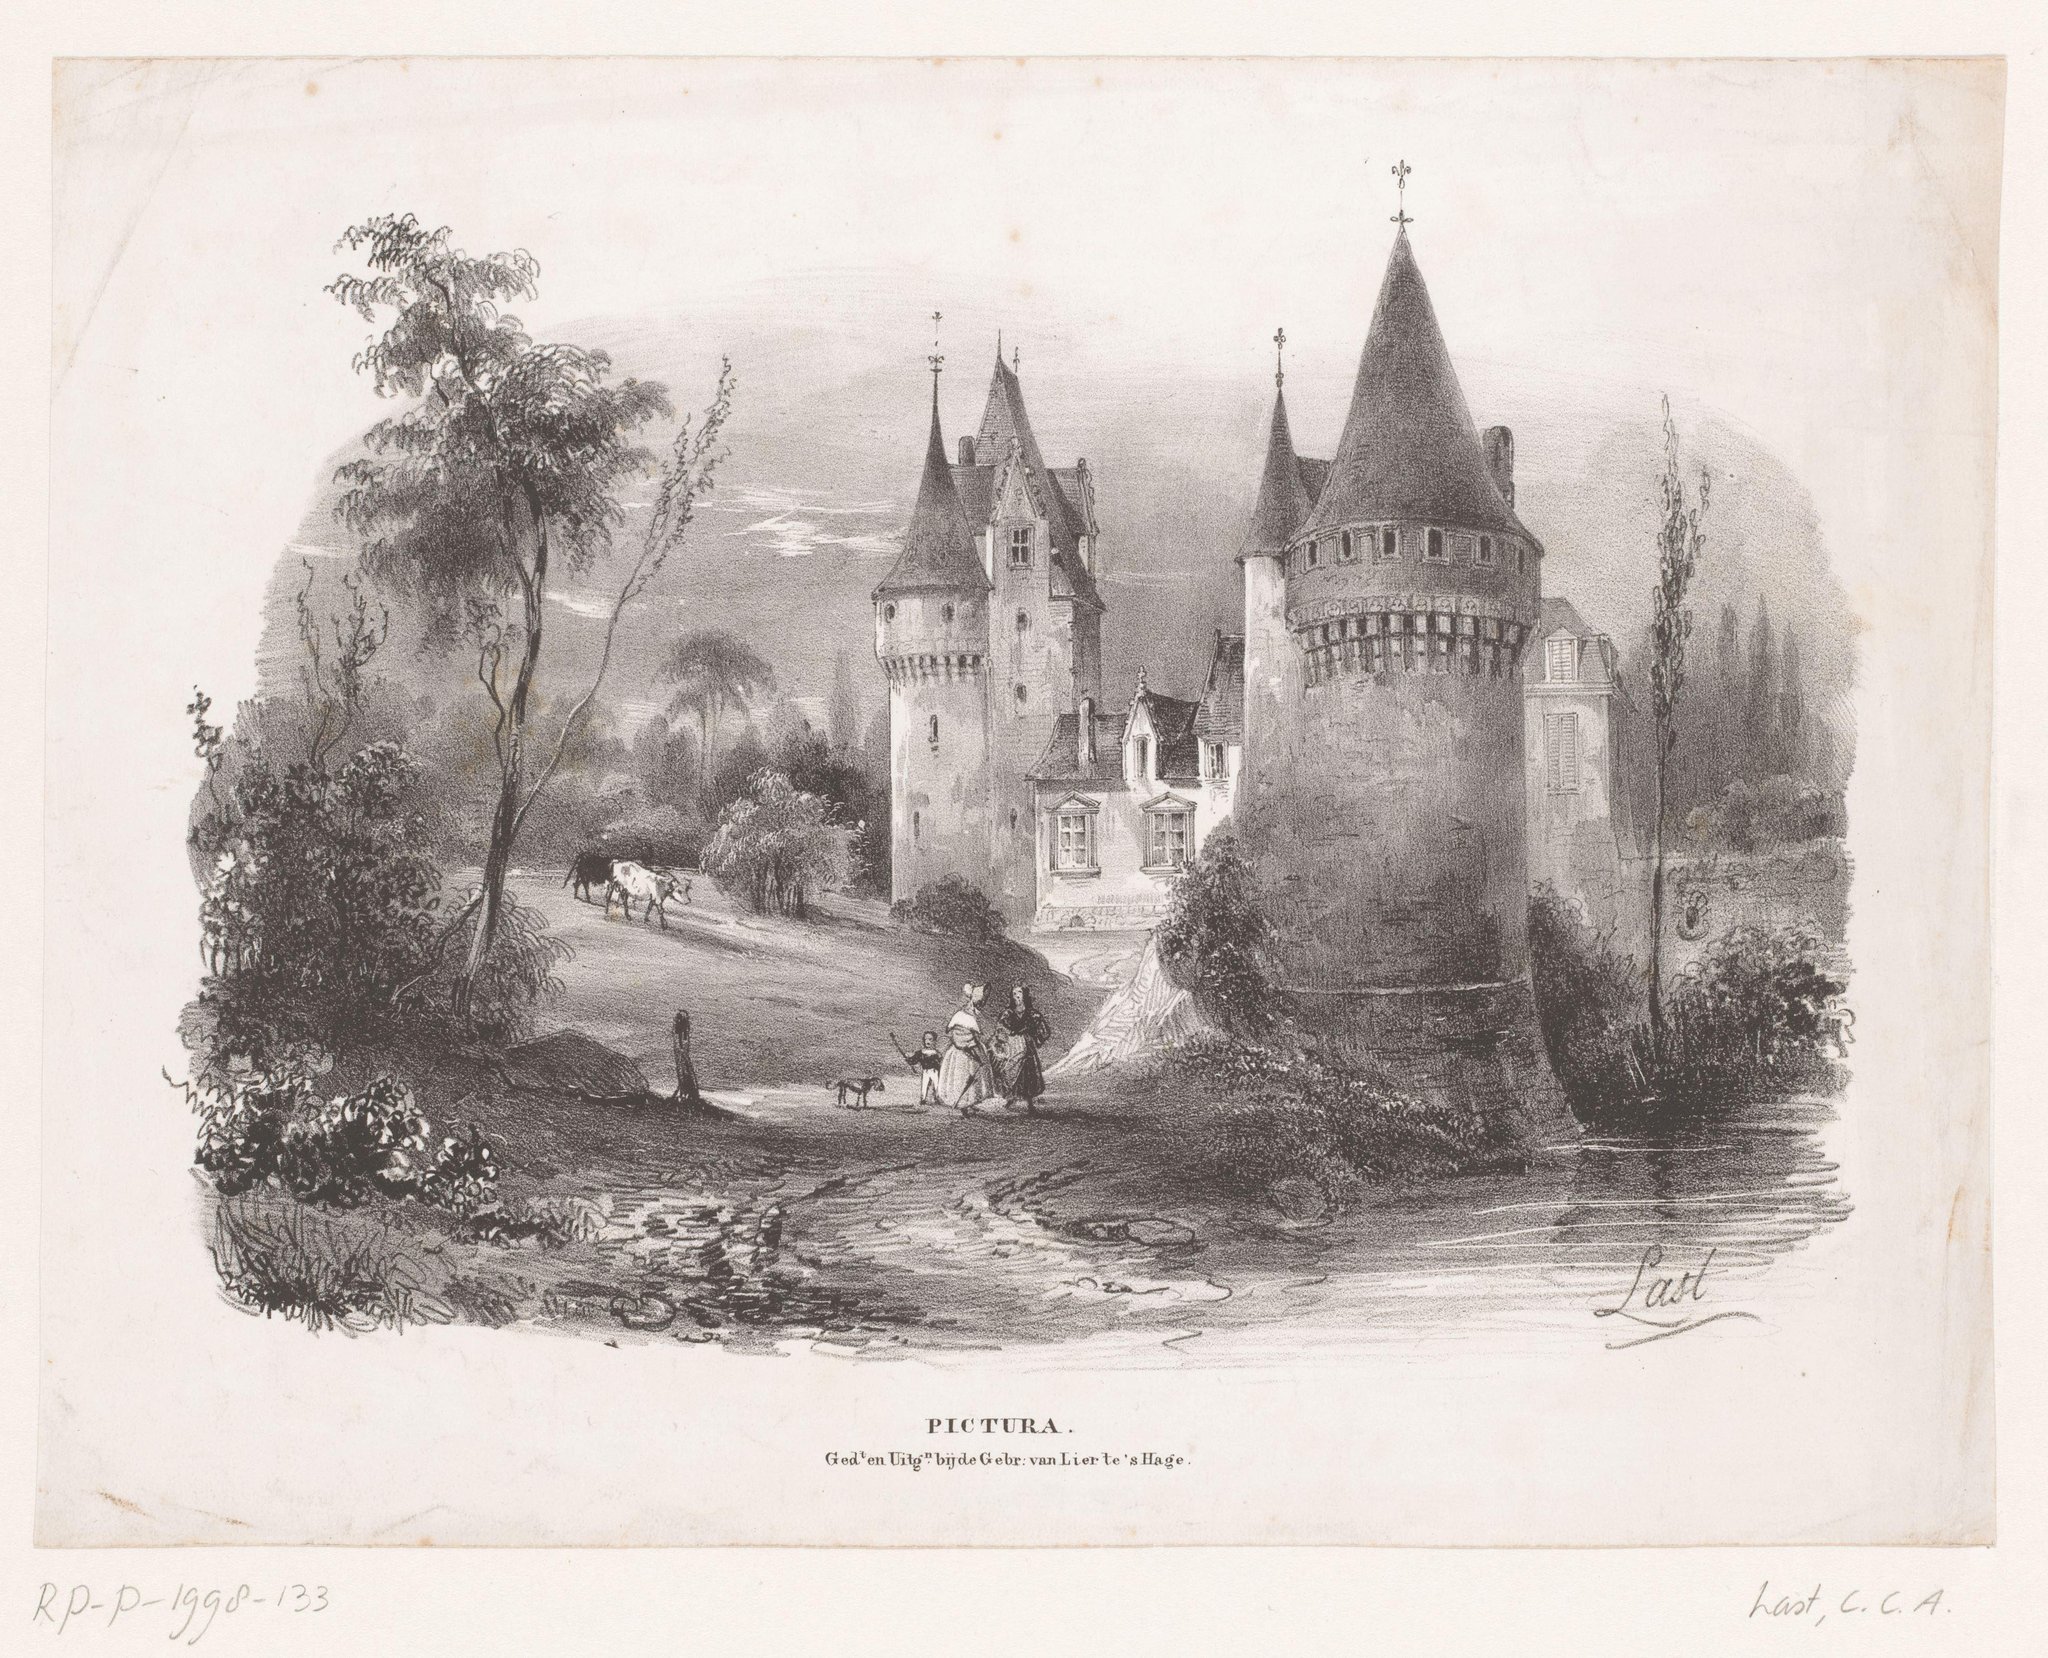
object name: print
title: Kasteel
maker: carel christiaan antony last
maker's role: print maker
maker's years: 1808-1876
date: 1834-1876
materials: paper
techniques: lithography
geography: the hague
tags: castle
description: Gezicht op een kasteel en een toren. Twee vrouwen, een kind en een hond lopen op een pad in de voorgrond. Links in de achtergrond staan twee koeien.